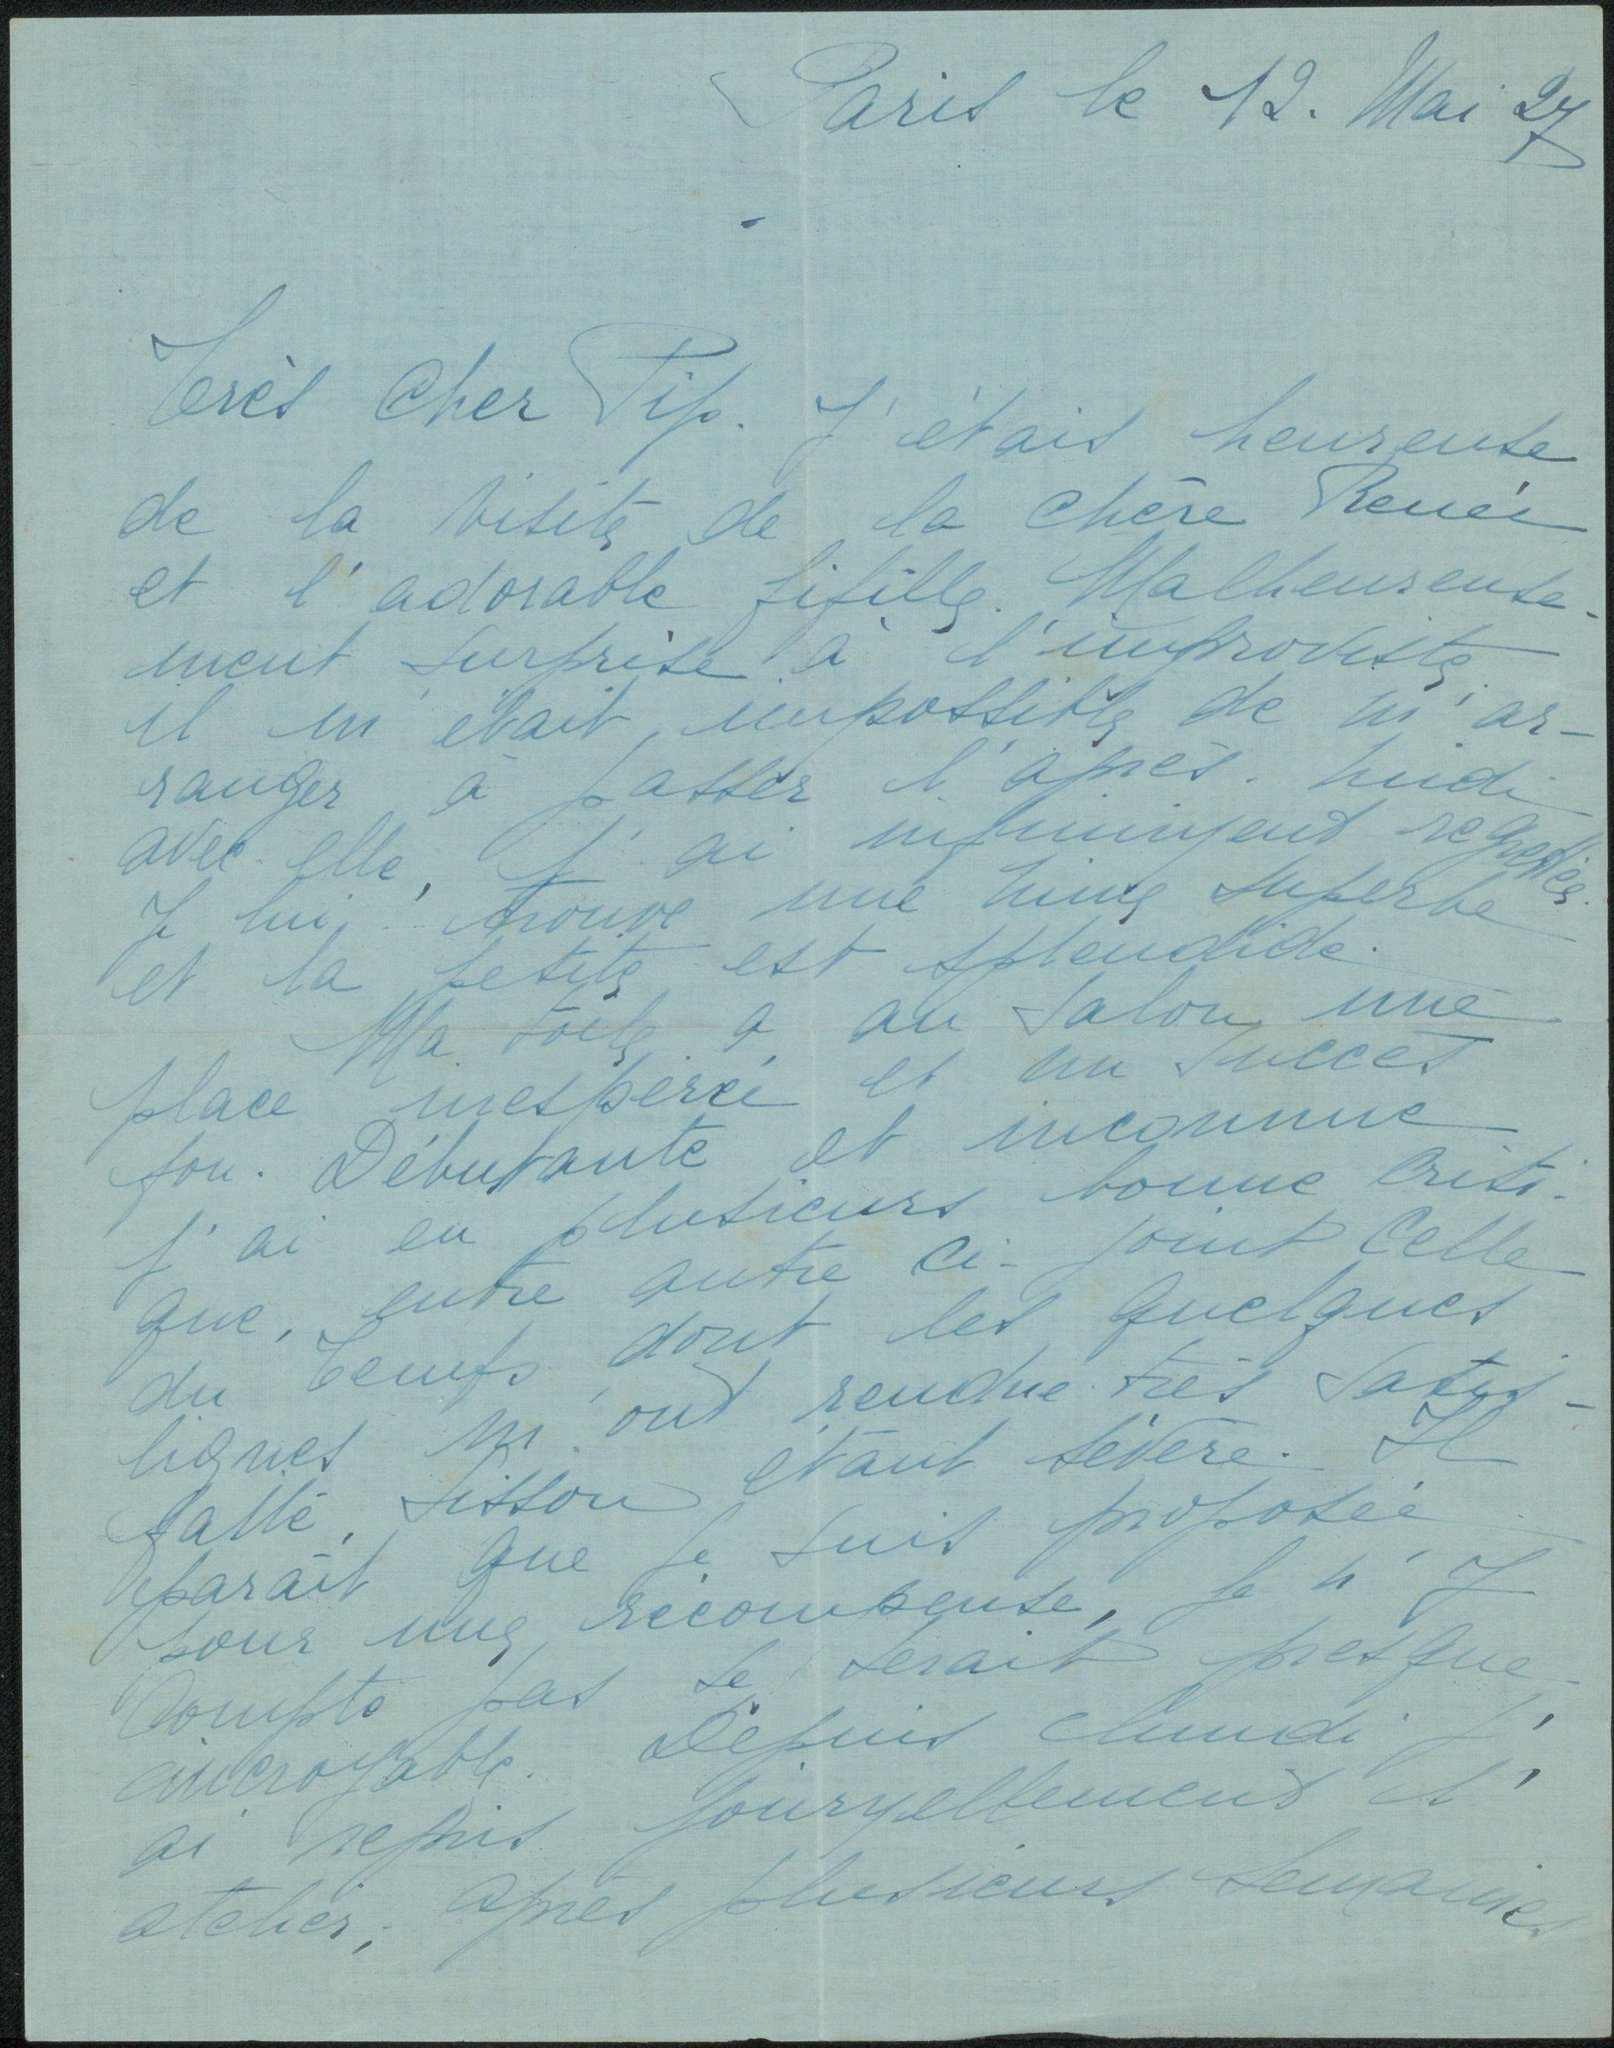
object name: letter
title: Brief aan Philip Zilcken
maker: rose imel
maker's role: draughtsman, painter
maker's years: 1901-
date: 1927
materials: ink, paper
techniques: pen, writing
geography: paris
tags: françois thiébault-sisson, the hague, philip zilcken, criticizing and discussing art, art criticism, drawing, painting (including book-illumination, miniature-painting), workshop, studio of the artist (in general), exhibition ~ art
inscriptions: collector's mark: ‘RPK’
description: Krantenknipsel RP-D-1982-43-IMEL-DOC.10 is verstuurd als bijlage bij deze brief.